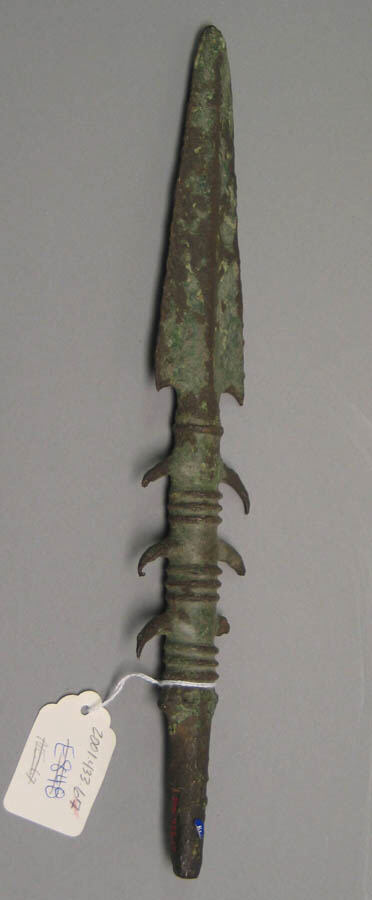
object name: harpoon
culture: indian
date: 1500-500 BCE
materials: copper